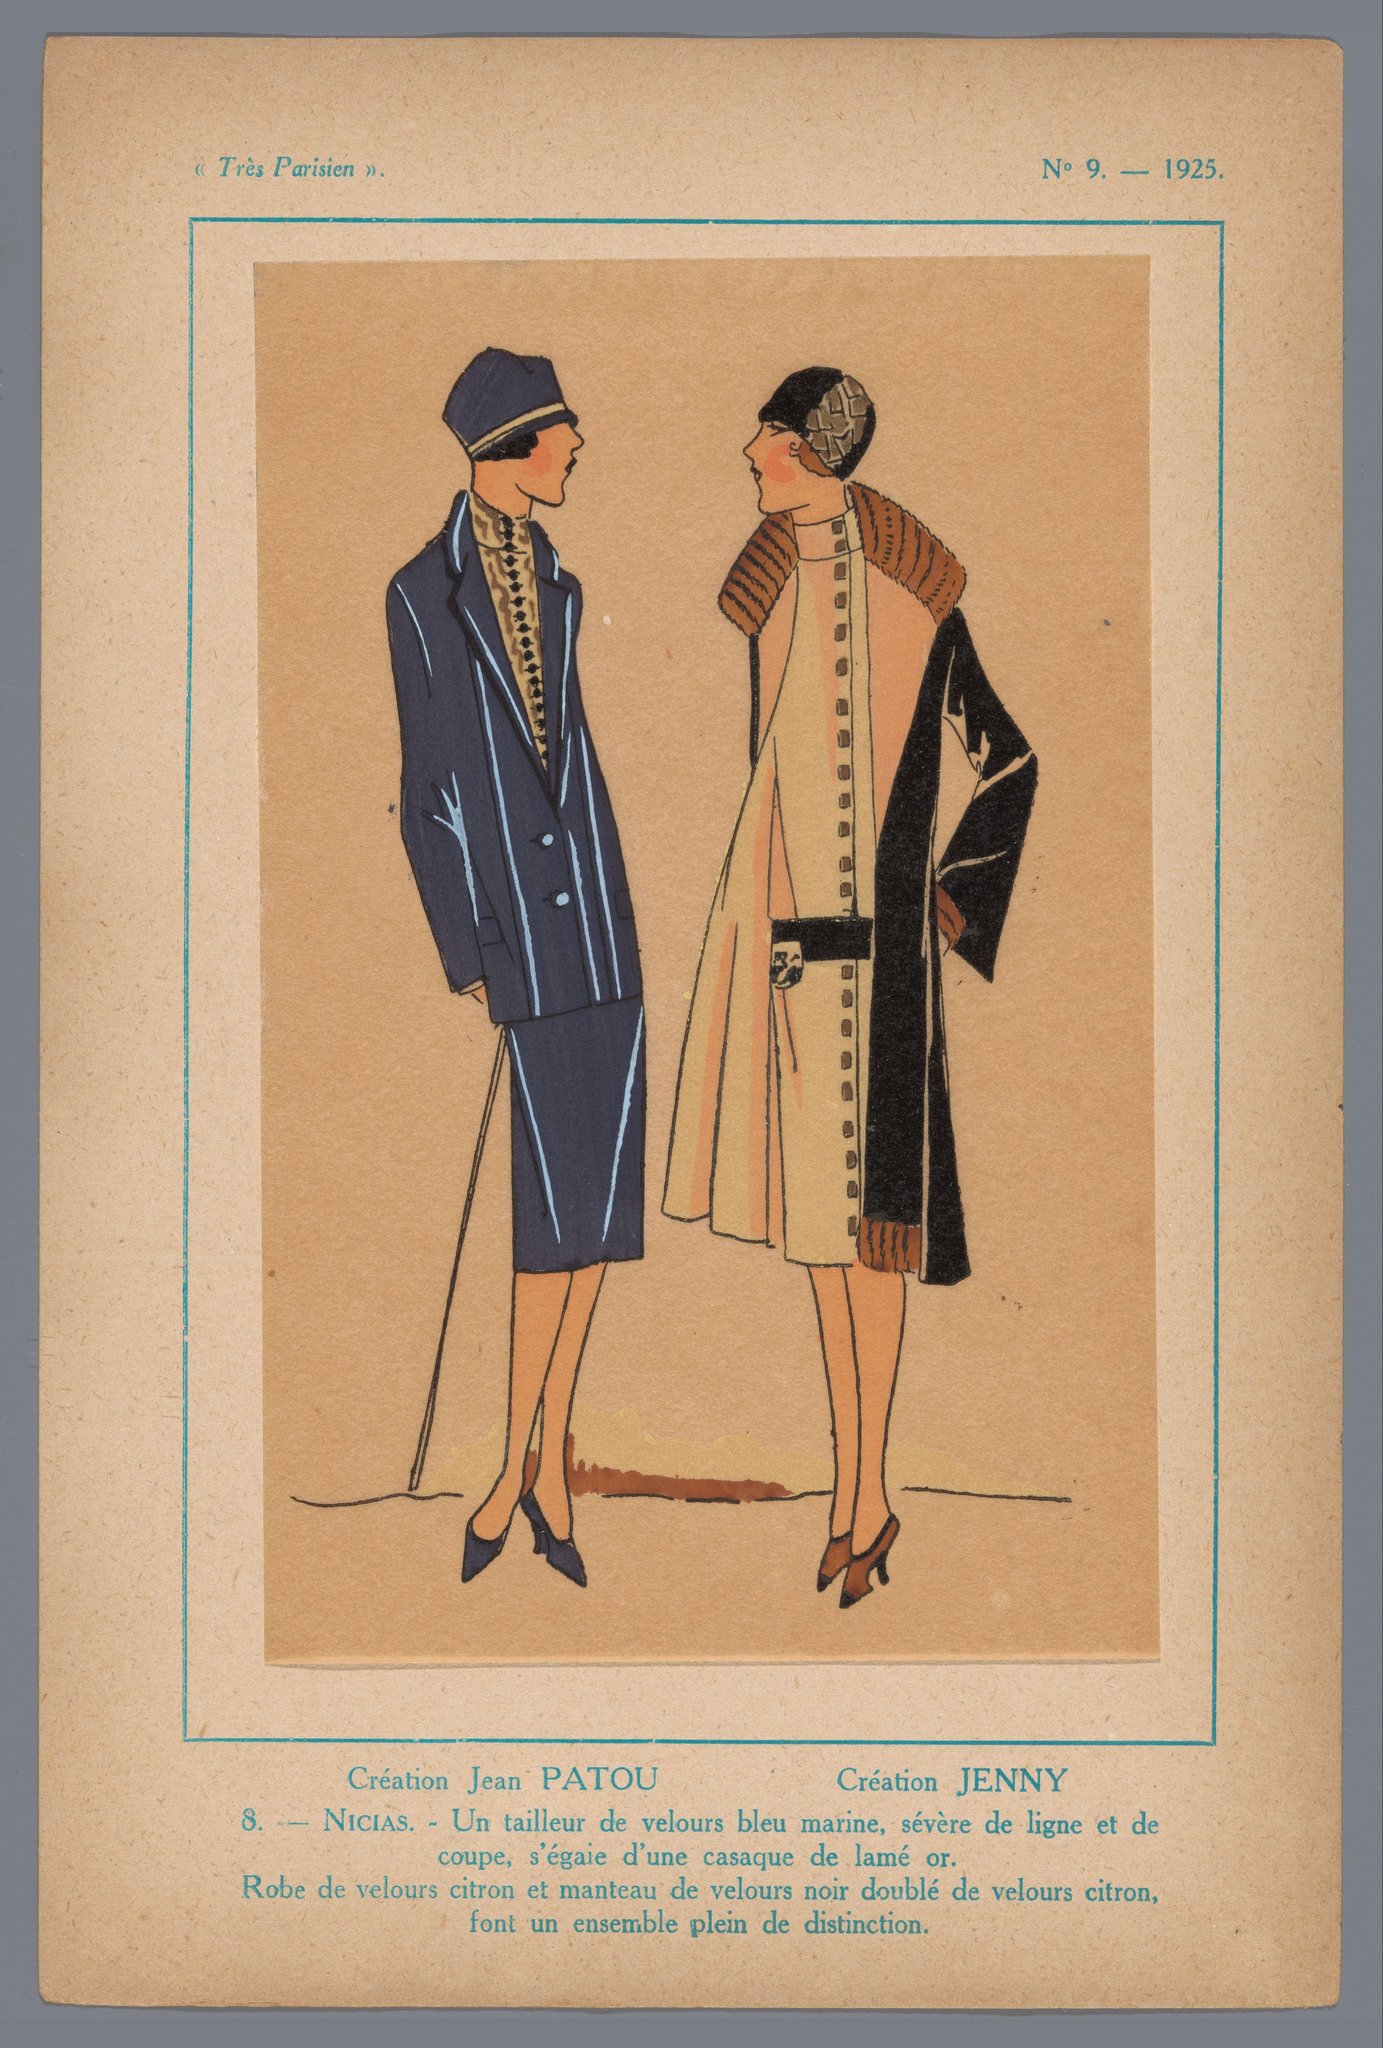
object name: fashion print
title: Très Parisien, 1925, No. 9, Pl. 8: Création Jean PATOU Création JENNY - NICIAS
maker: g-p. joumard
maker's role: publisher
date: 1925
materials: paper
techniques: hand coloring, letterpress printing, lithography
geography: paris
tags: ensembles of pieces of clothing (tailleur) (+ women's clothes), fashion plates, dress, gown (+ women's clothes)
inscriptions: caption: ‘8. - NICIAS. - Un tailleur de velours bleu marine, sévère de ligne et de coupe, s'égaie d'une casaque de lamé or. Robe de velours citron et manteau de velours noir doublé de velours citron, font un ensemble plein de distinction.’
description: Mantelpakje van blauw fluweel met een goudlamé blouse. Ensemble bestaand uit een japon van ciroengeel fluweel en een mantel van zwart fluweel, met citroengele voering. Prent uit het modetijdschrift Très Parisien...La Mode, Le Chic, L'Élégance (1920-1936)